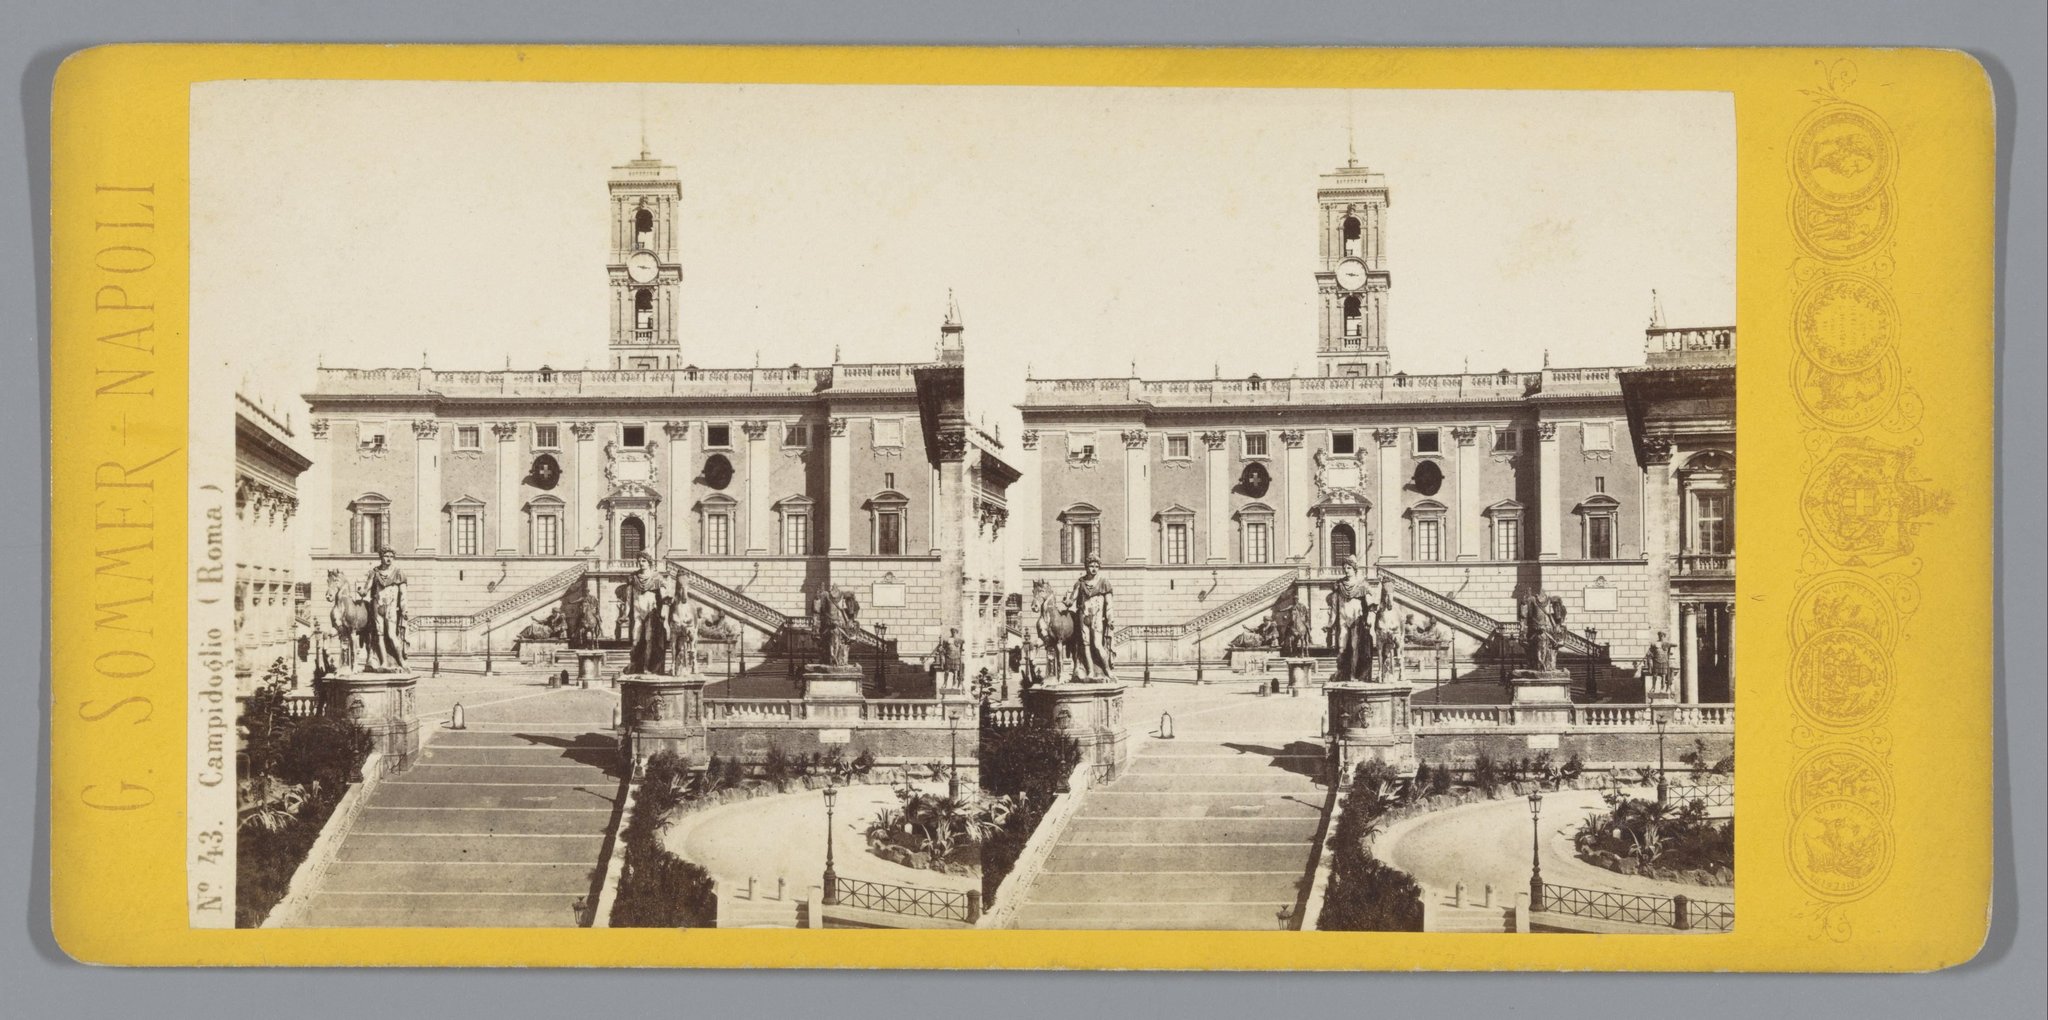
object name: stereograph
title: Campidoglio (Roma)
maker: giorgio sommer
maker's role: fotograaf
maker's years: 1834-1914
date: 1860-1880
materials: cardboard, photographic support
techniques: albumen print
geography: rome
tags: square, place, circus, etc.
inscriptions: inscription: ‘Campodoglio Rome’, number: ‘No. 43.’